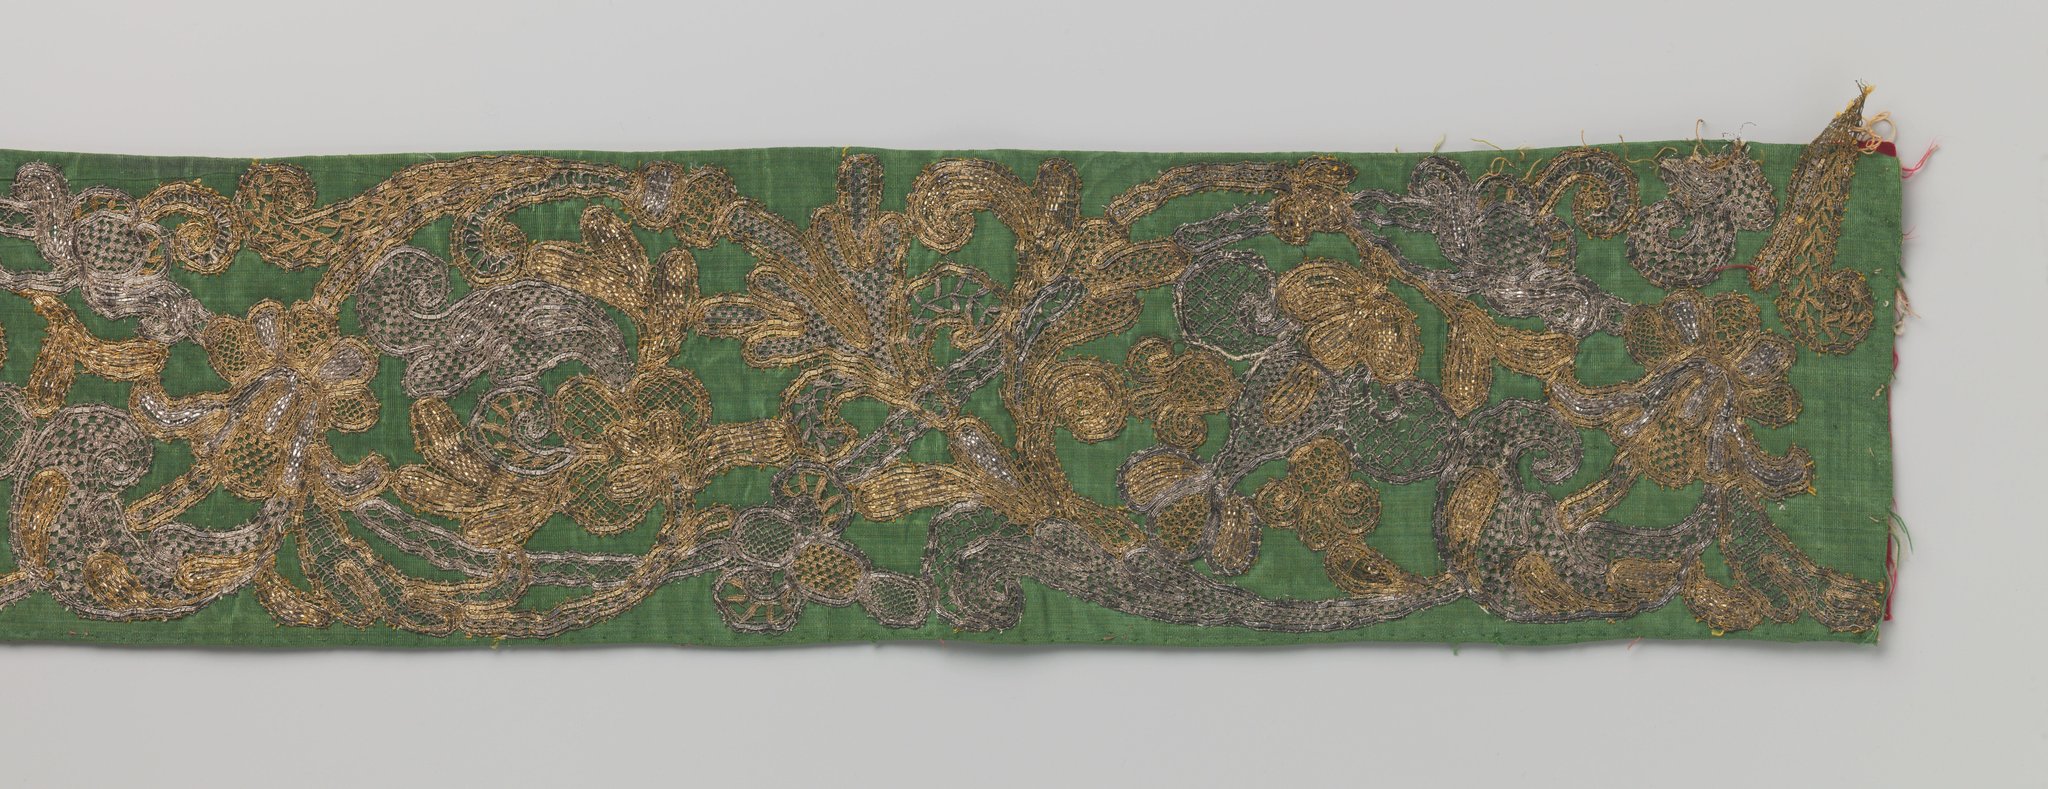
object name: strip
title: Strook groen zijde met grote bloemen en bladeren van zilverkant en goudkant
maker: Anonymous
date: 1680-1720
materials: gold thread, silk, thread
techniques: lace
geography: western europe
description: Strook rood gevoerde groene zijde waarop een versiering is genaaid van gekloste zilverkant en goudkant. Het doorlopende patroon bestaat uit grote bloemen en bladeren. Binnen contourlijnen van drie tegen elkaar aan geplaatste draden zijn siergronden en motiefjes in vormslag aangebracht. Er is gewerkt met lamelgouddraad en - zilverdraad en met filégaren, in verschillende diktes. Aan de strook hangt een etiket van de kunsthandel: "French & Co, Inc.", waar de strook is aangekocht.